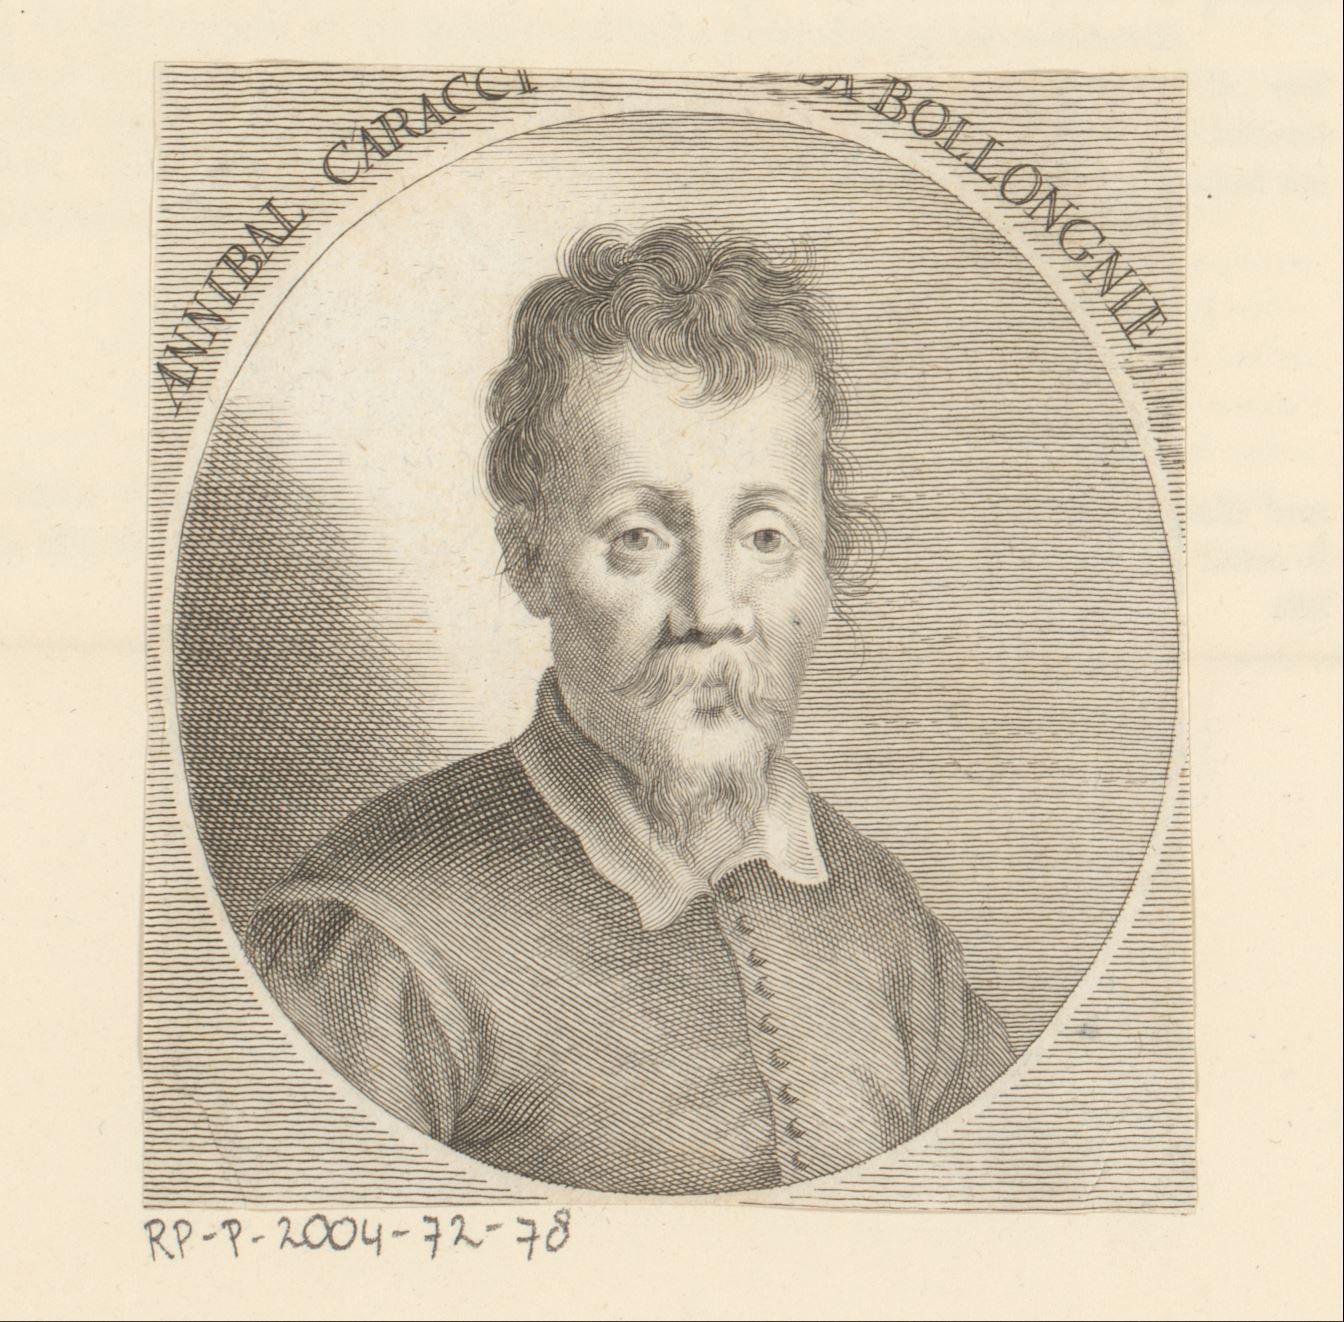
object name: print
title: Portret van Anibale Caracci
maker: philipp kilian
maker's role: print maker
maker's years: 1628-1693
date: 1768-1775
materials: paper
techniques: engraving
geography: nuremberg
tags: draughtsman, annibale carracci, historical persons, portrait, self-portrait of painter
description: Prent uit: Sandrart, Joachim von. Teutsche Academie der Bau- Bildhauer- und Maler-Kunst: worinn die Regeln und Lehrsätze dieser Künste gegeben. 14 dln. Neurenberg: erven Johann Andreas Endter, [1774], dl. 7, p. S. De samensteller heeft deze prent in het album geplakt als illustratie bij: Pilkington, Matthew en Johann Heinrich Füssli. A dictionary of painters, from the revival of the art to the present period. 4 dln. Londen: John Crowder, 1805, dl. 1, p. 103.